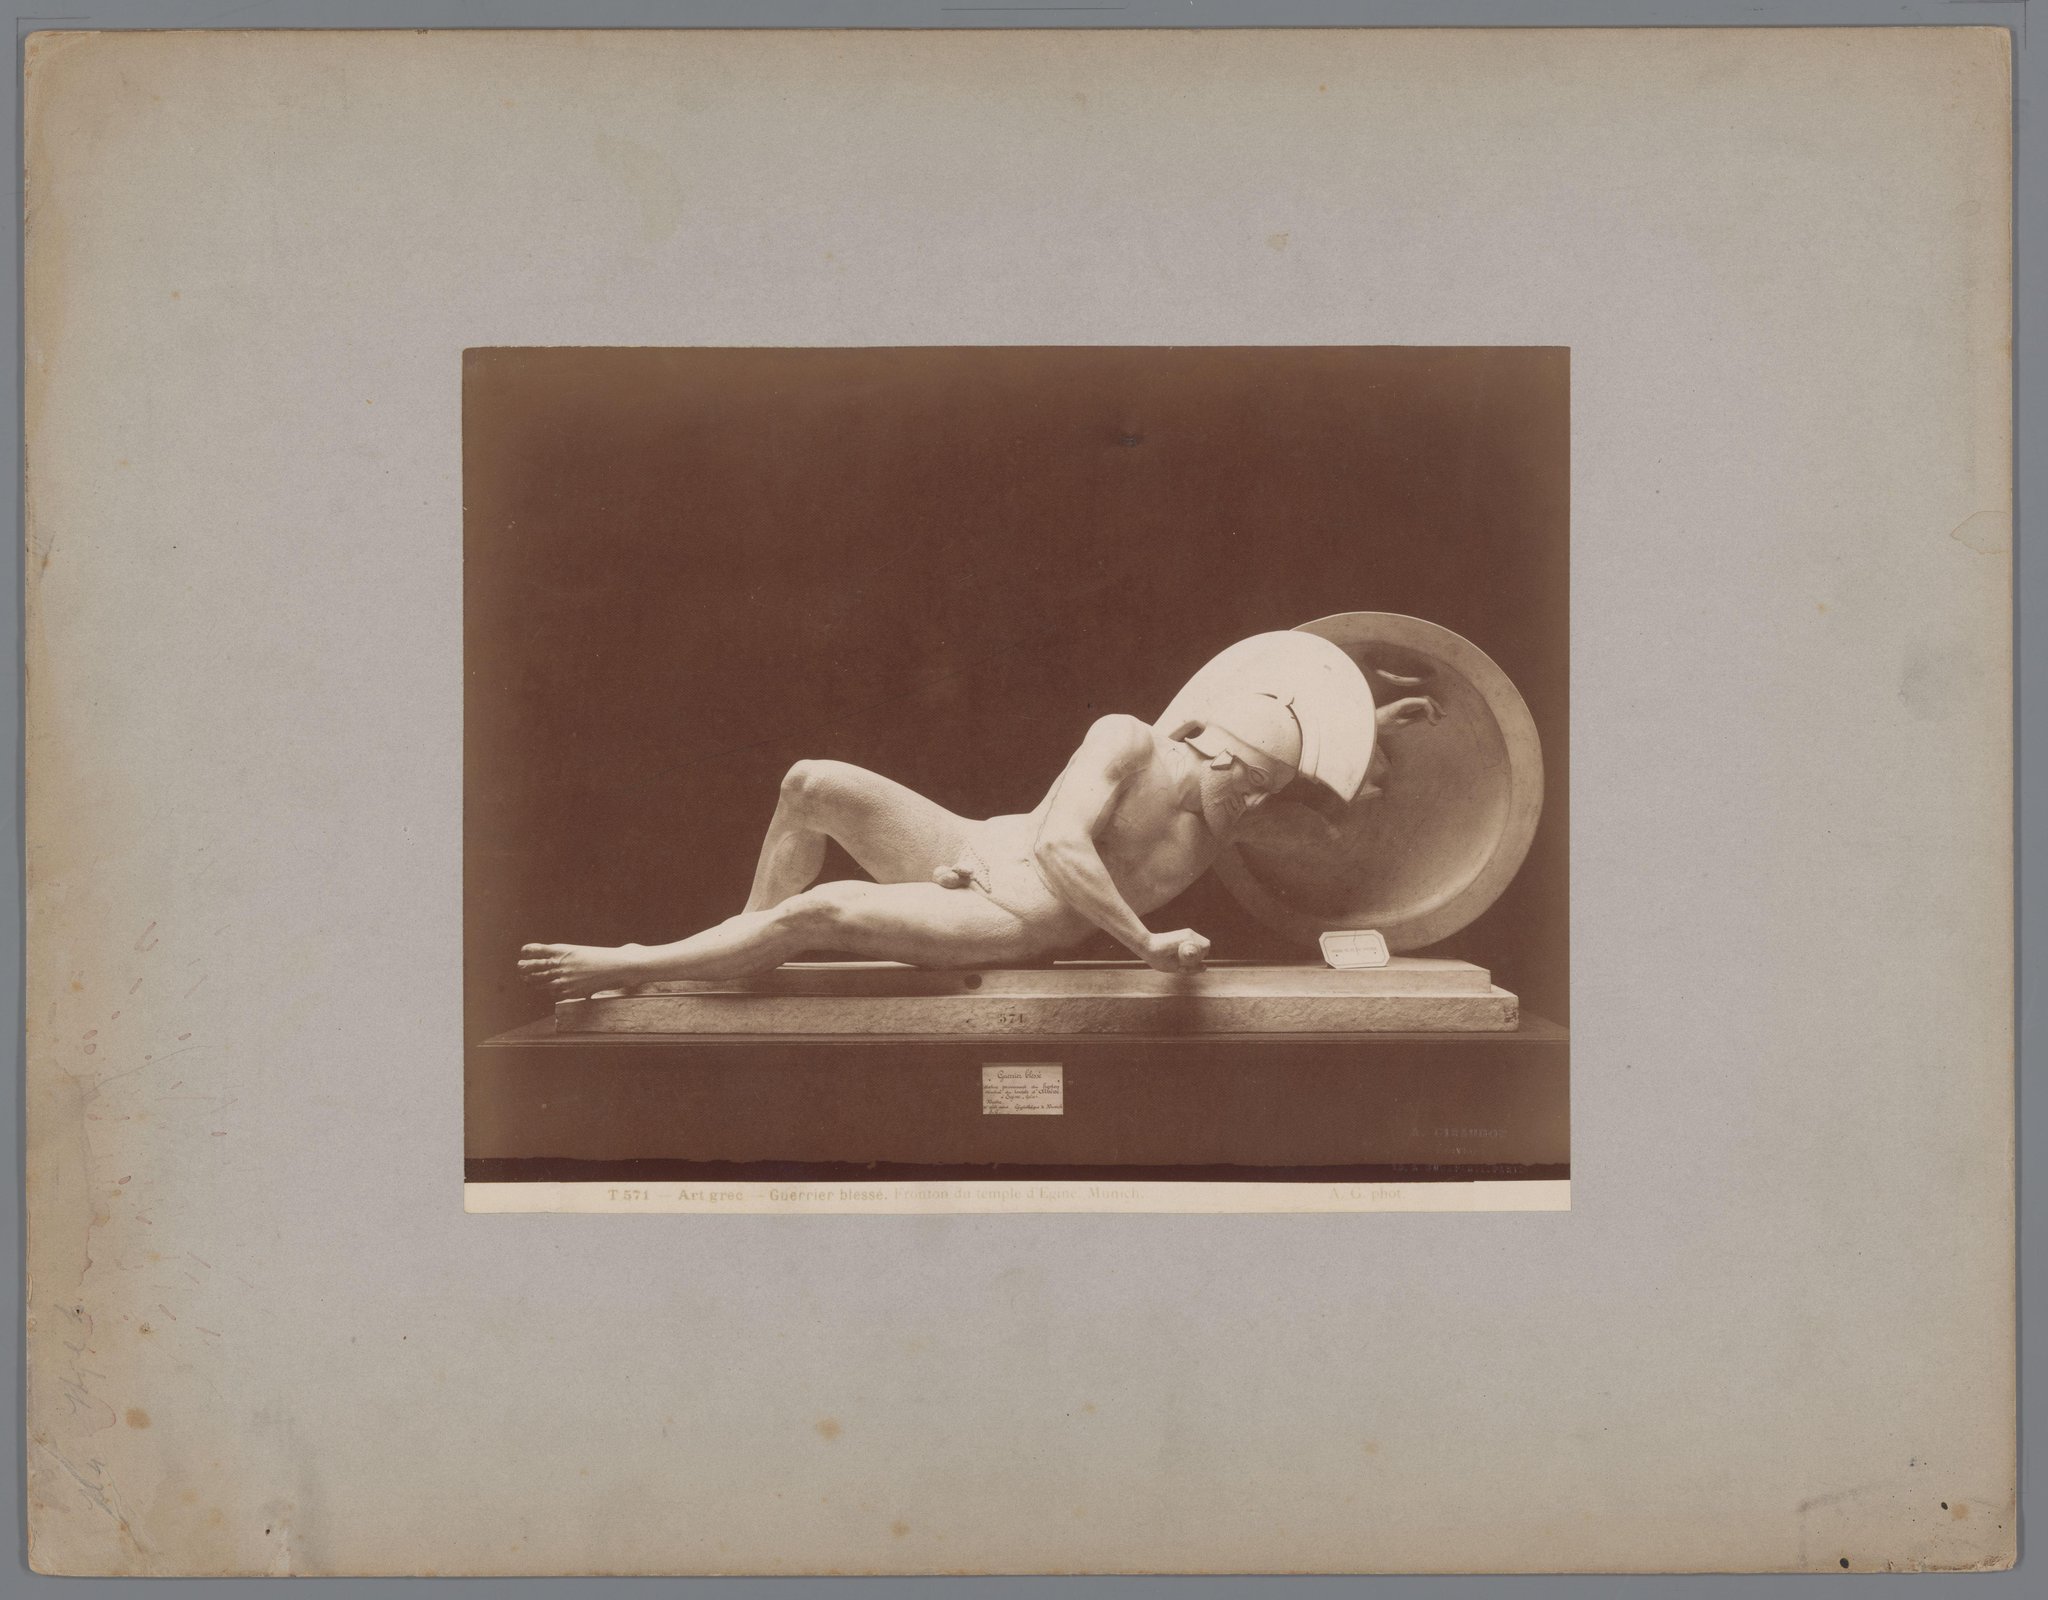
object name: photograph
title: Art grec - Guerrier blessé. Fronton du temple d'Egine. Munich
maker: adolphe giraudon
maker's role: publisher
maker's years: 1849-1929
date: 1875-1900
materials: cardboard, photographic support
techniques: albumen print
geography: paris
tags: helmet, protective weapons: shield, private soldier, sculpture, lying figure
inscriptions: collector's mark: Lugt 3937, number: ‘T 571’, name: ‘A. GIRAUDON ÉDITEUR 15. R. BONAPARTE. PARIS’, inscription: ‘pl 4 stijl k’